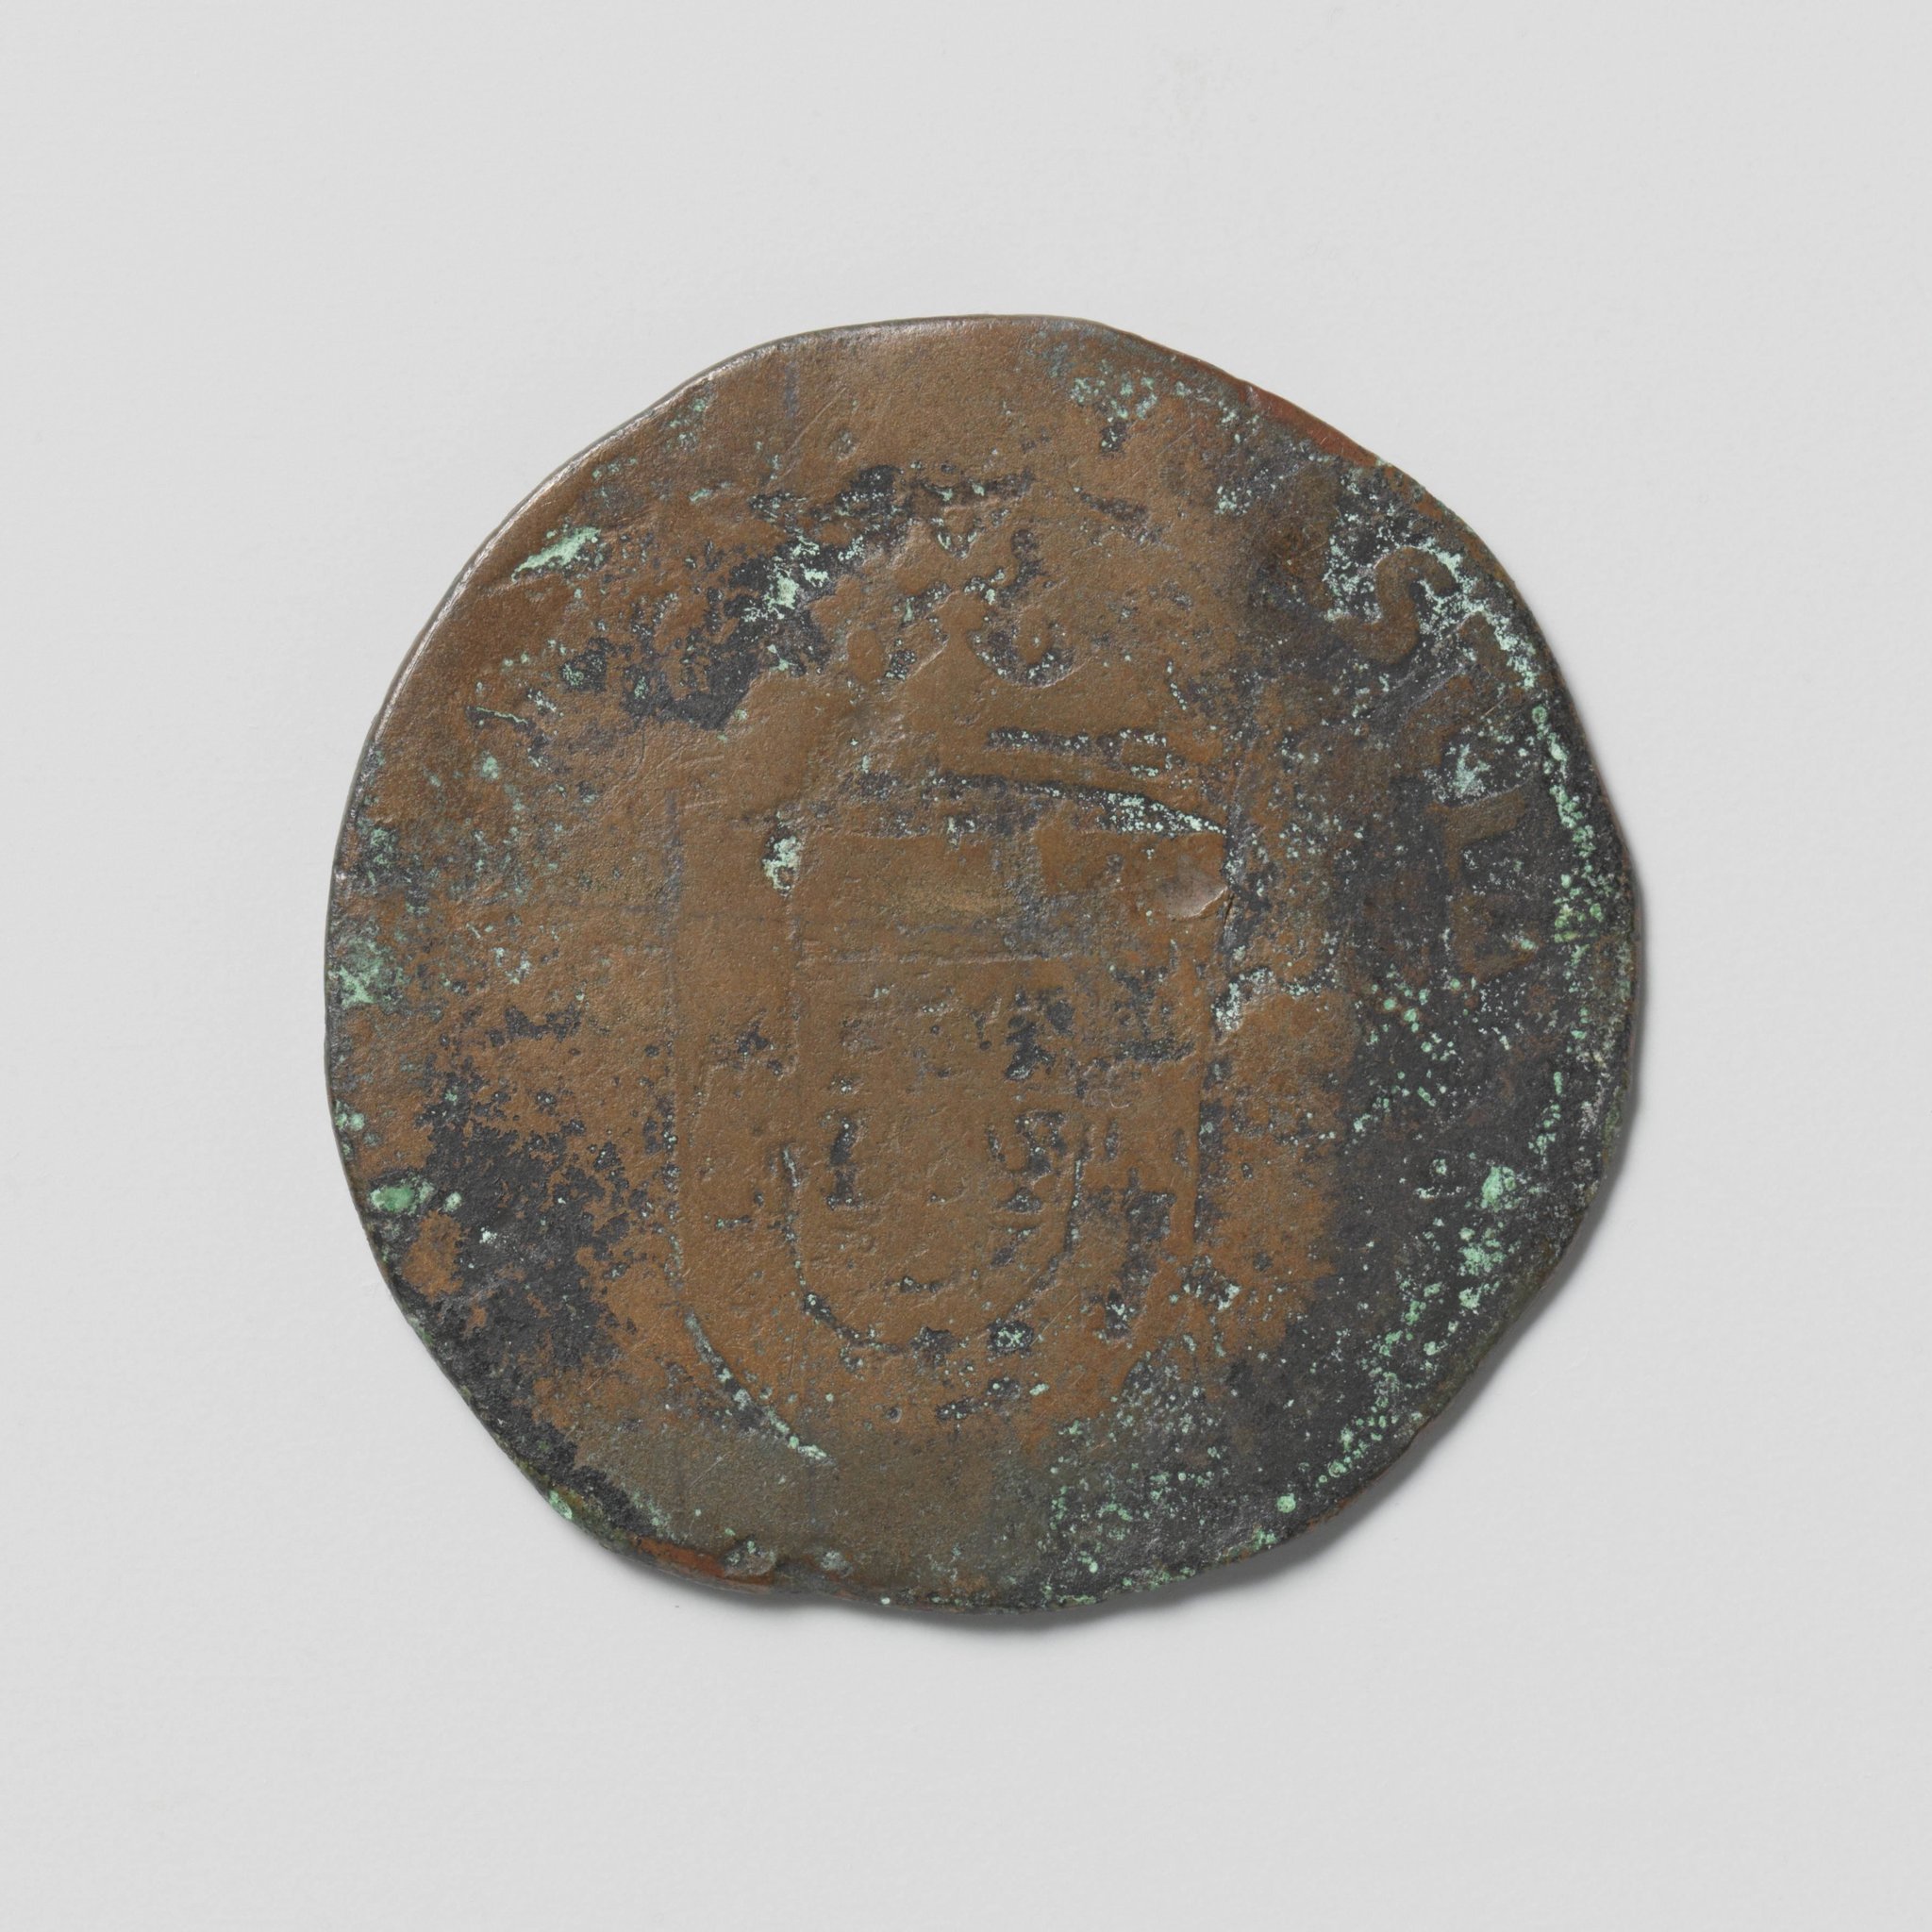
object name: coin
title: Vijfreisstuk, Portugese munt of duit ter waarde van vijf reis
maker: Anonymous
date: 1590-1596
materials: copper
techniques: striking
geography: portugal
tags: willem barendsz., amsterdam, jacob van heemskerck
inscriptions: weerszijden, geslagen: Wapen Portugal en restant tekst: "bastian", weerszijden, geslagen: Onleesbaar